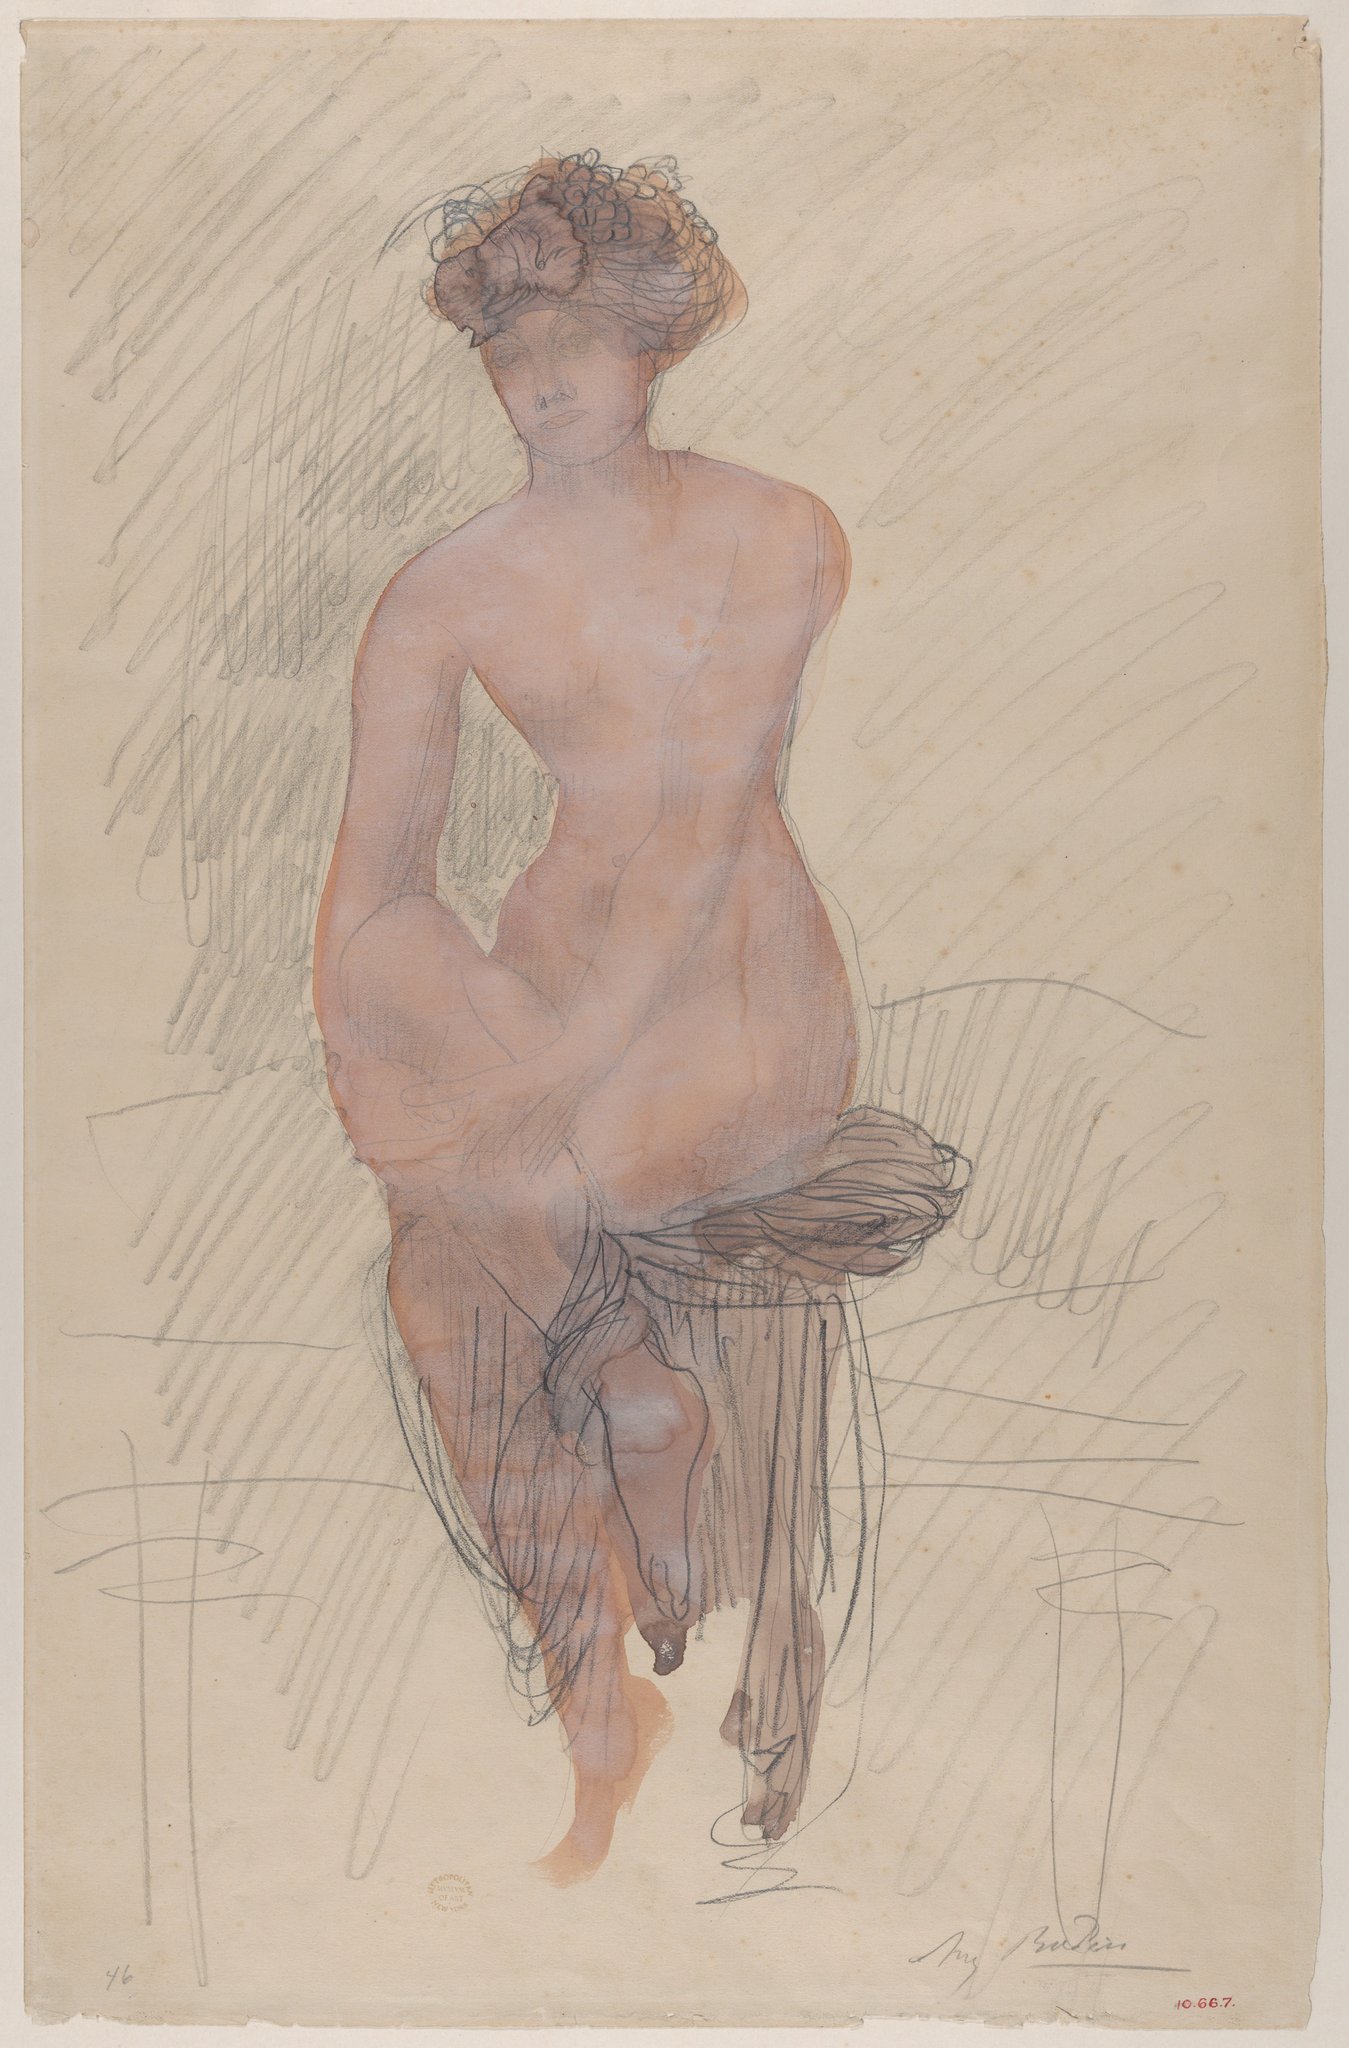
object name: drawing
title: Seated female nude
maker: auguste rodin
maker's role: artist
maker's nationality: french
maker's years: 1840-1917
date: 1900-1910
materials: gouache, graphite, watercolor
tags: female nudes